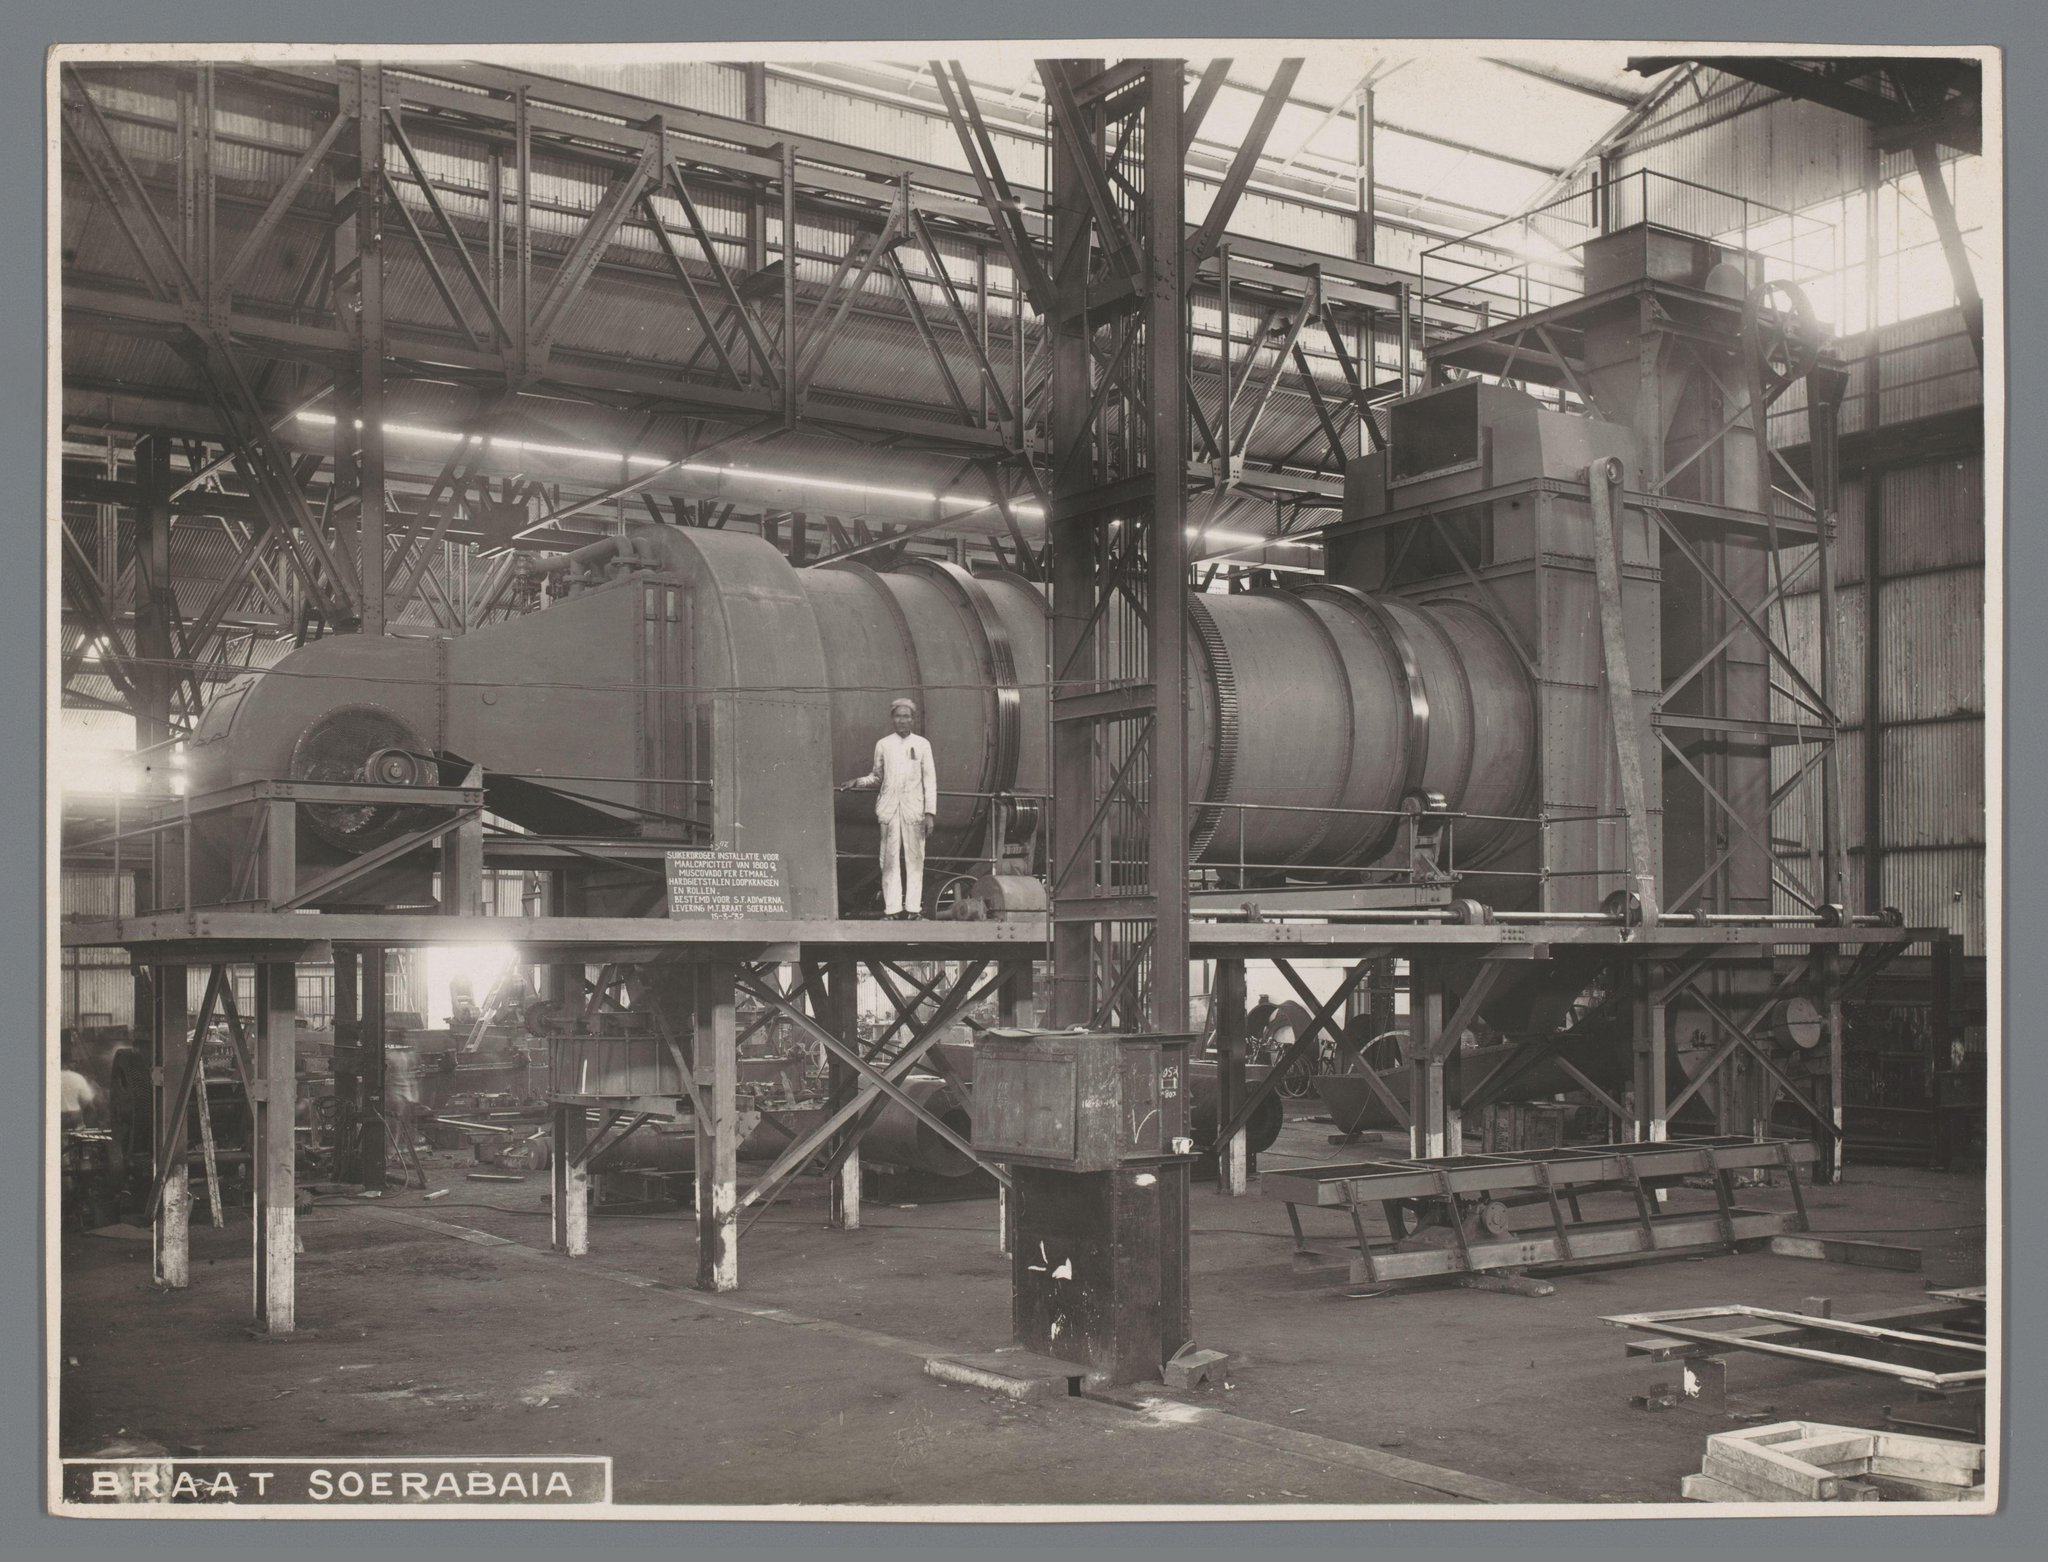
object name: photograph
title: Suikerdrooginstallatie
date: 1932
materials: photographic support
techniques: gelatin silver print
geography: surabaya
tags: colonial system, factory-interior, machine shop, machines; parts of machines; tools and appliances, (non-fruit) products of plants or trees: sugarcane, java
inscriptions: company name: ‘Kunst Foto Atelier Isken’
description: Suikerdroger vervaardigd in 1932 voor de Suikerfabriek Adiwerna ten zuiden van Tegal. Onderdeel van de multomap met foto's van machines van de N.V. Machinefabriek Braat te Soerabaja bestemd voor de Nederlandse suikerindustrie op Java, uit de periode 1917-1938.